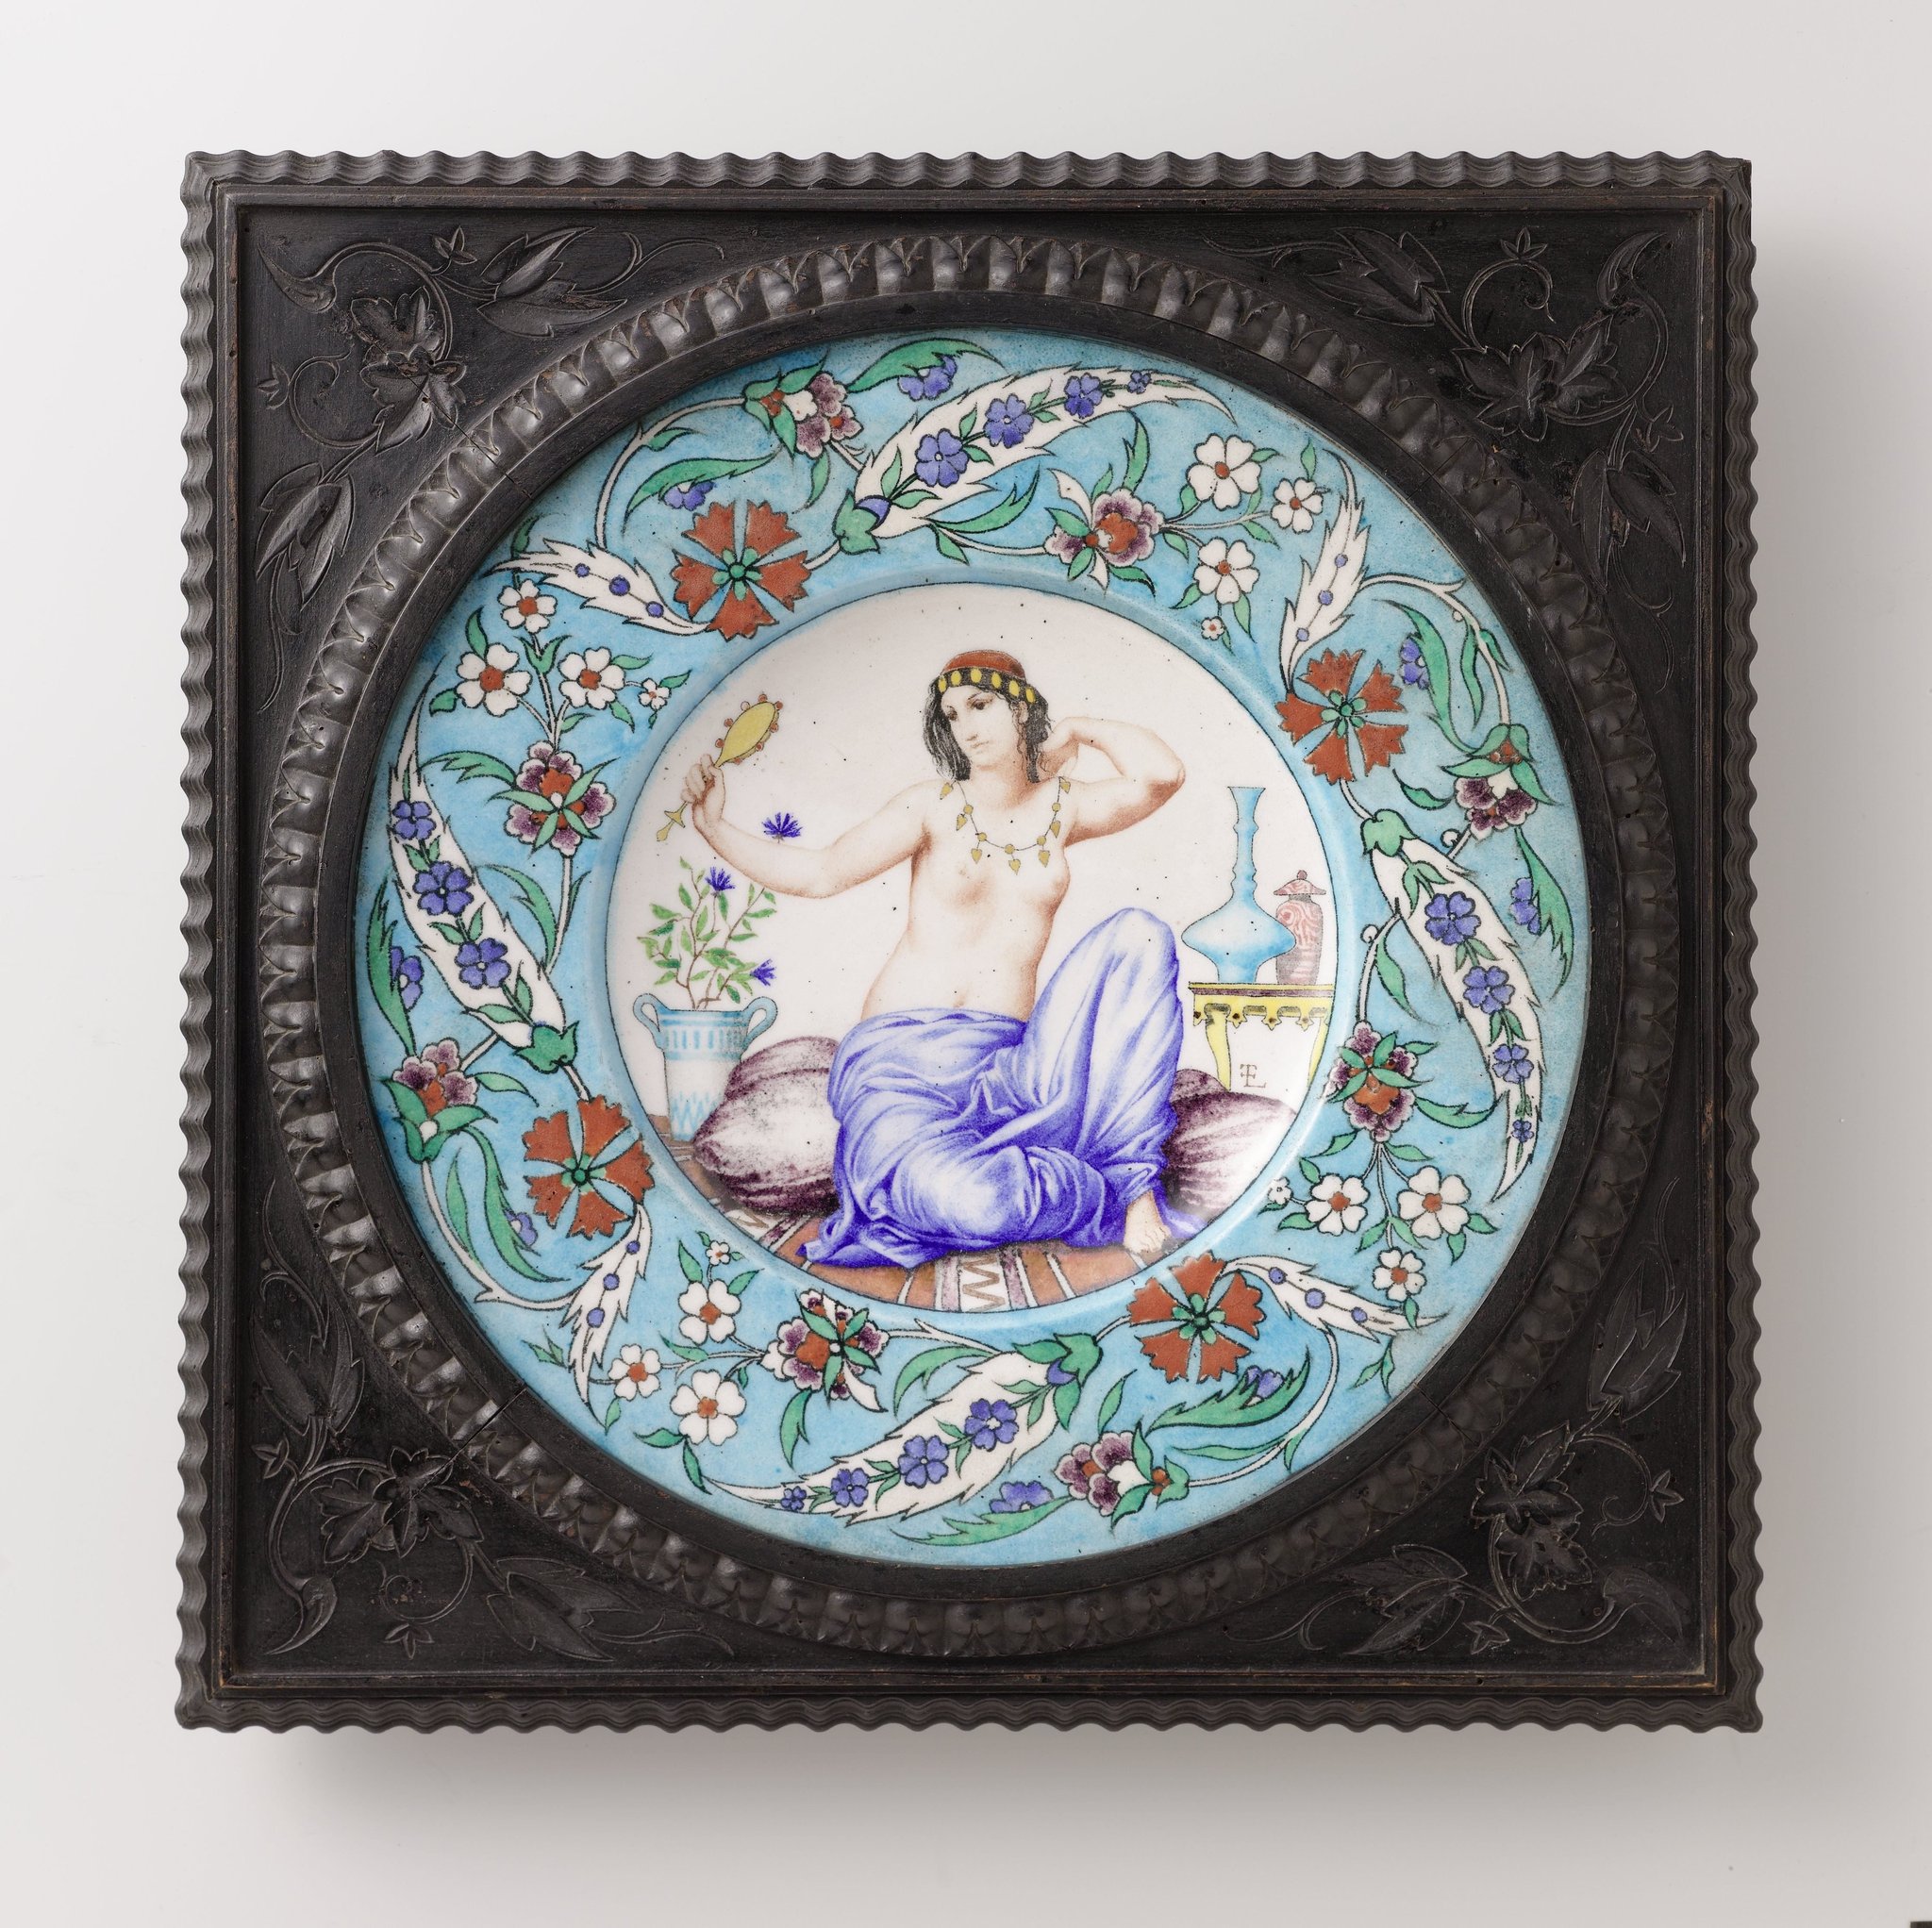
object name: wandbord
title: Wandbord met in kussens gezeten odalisque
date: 1867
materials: earthenware, wood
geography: paris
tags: odalisque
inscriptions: signature, monogram: ‘FE’, inscription: ‘No. 125 de l'Exposition Universelle de 1867 (Peinture d'Ehrmann)’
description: Wall plate. Earthenware in frame of deal stained black. Paris, c. 1867, by Théodore Deck, decorated by François Emile Ehrmann.